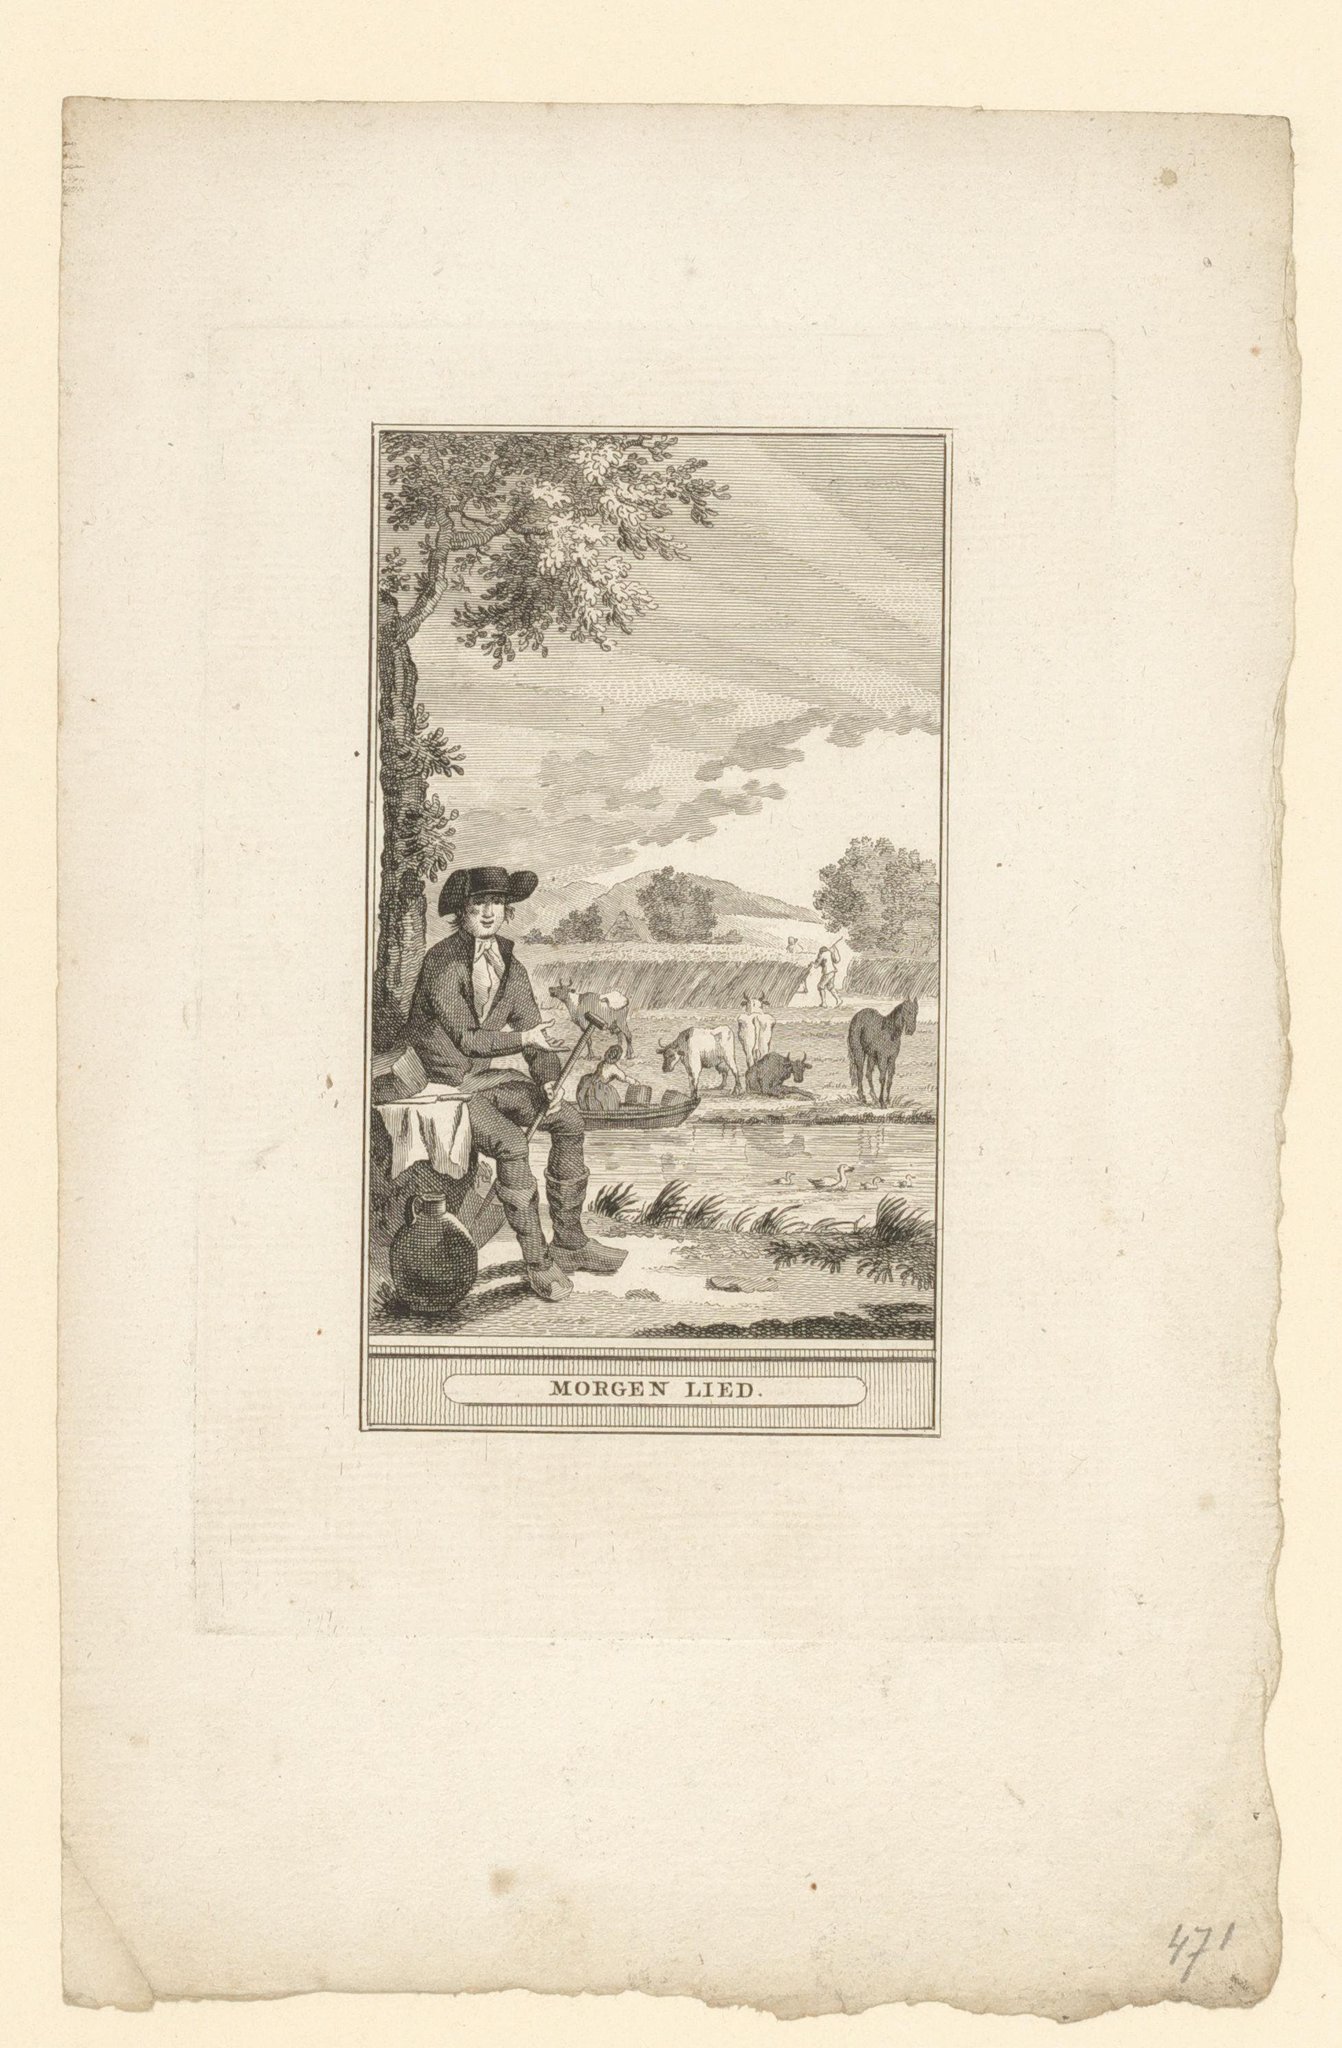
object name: print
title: Man zittend aan het water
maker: Anonymous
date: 1838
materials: paper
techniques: etching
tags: sitting figure, open-air recreation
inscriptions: collector's mark: Lugt 1641, stamp, stamp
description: Man zittend aan het water. Op de achtergrond vee en een akker waarop gewerkt wordt. Onderwerpsrubrieken binnen de Atlas Zeden en Gewoonten: Handel, nijverheid en verkeer, Buitenleven.